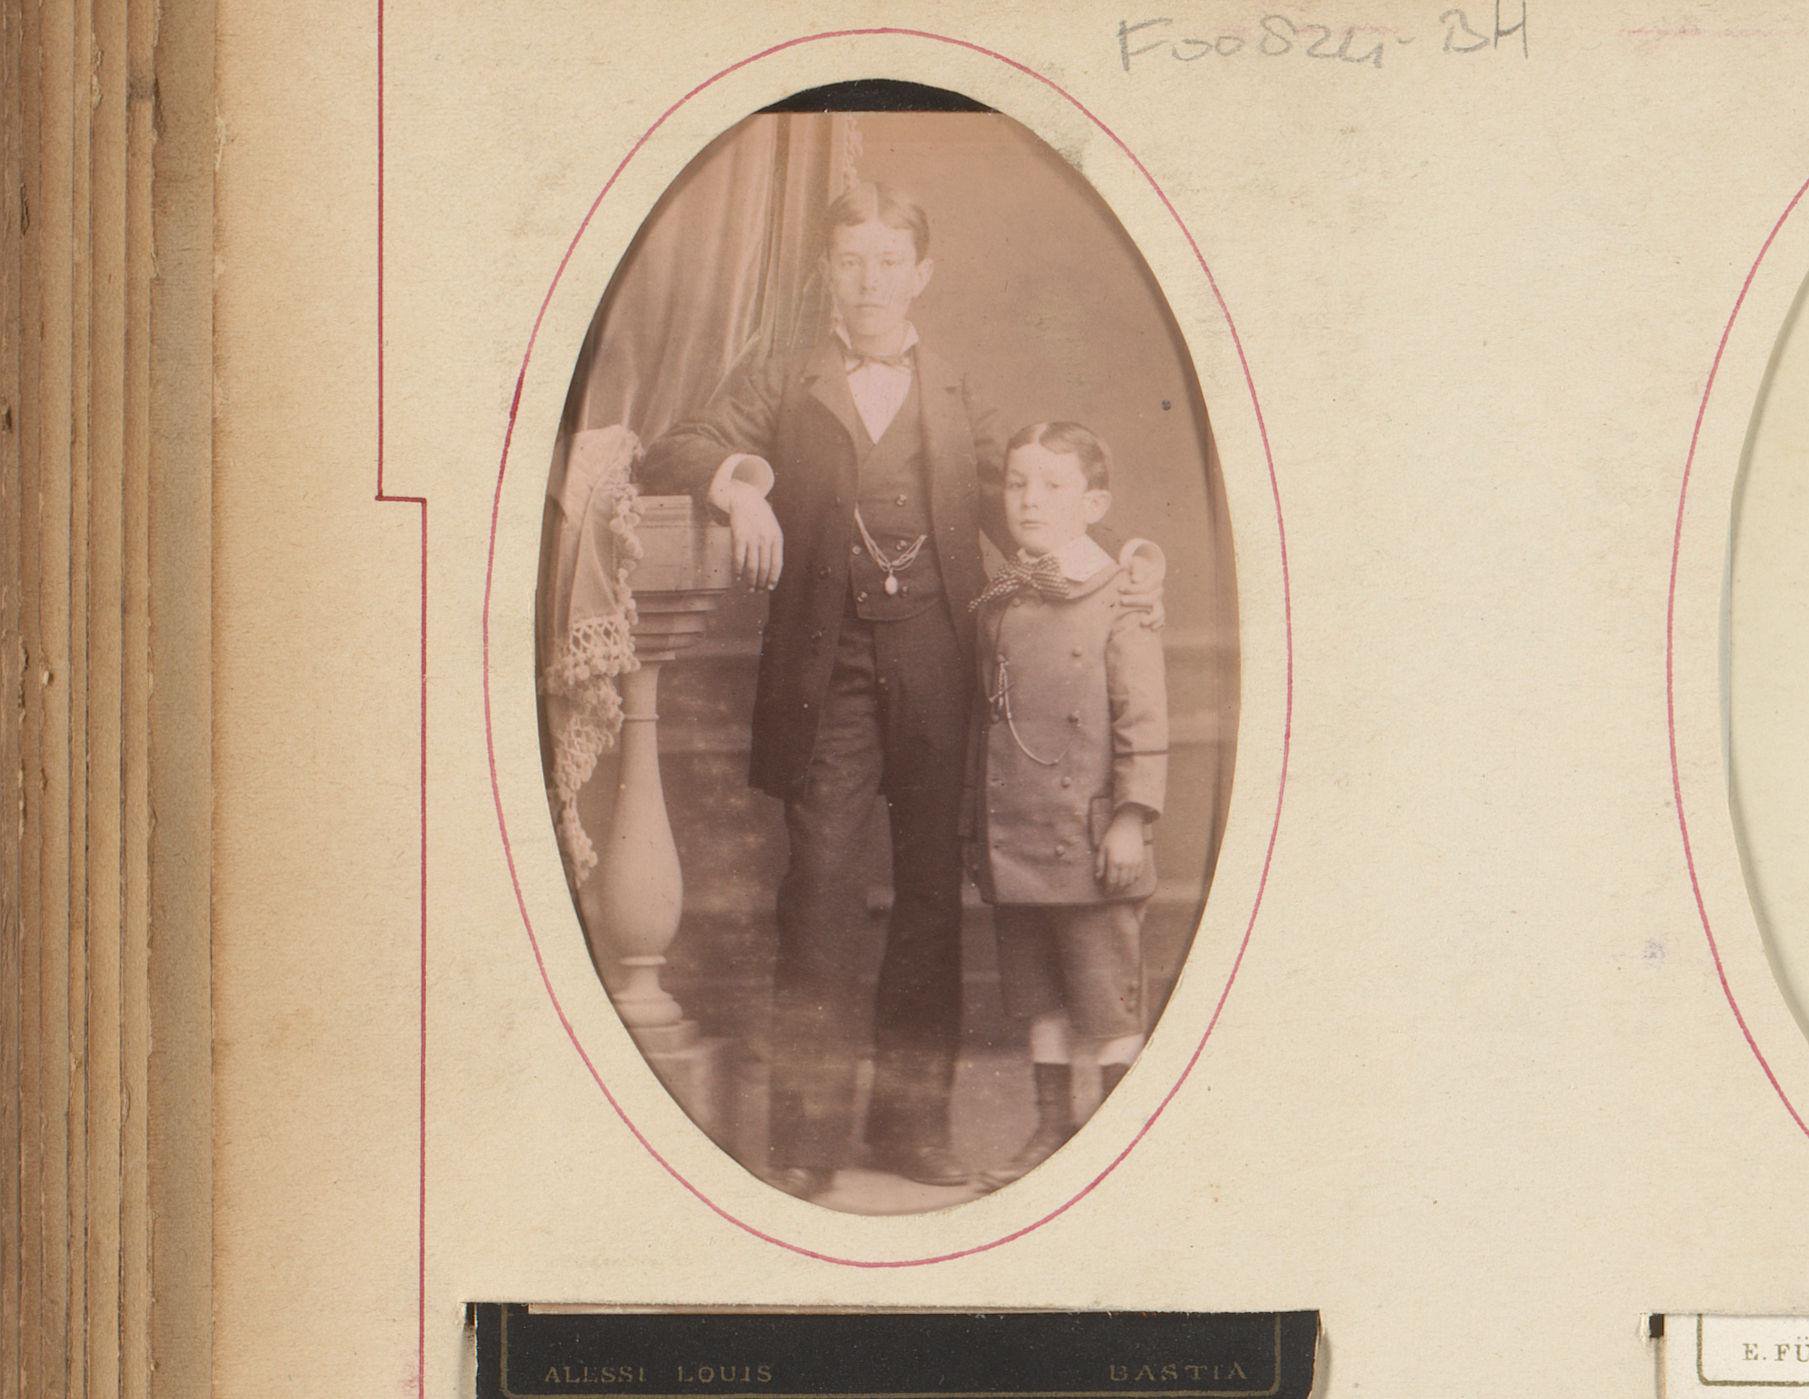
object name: album leaf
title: Dubbelportret van twee kinderen, aangeduid als Fils Pauli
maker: louis alessi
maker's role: fotograaf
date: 1854-1885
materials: cardboard, celluloid, paper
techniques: albumen print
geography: bastia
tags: boy (child between toddler and youth)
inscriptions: inscription: ‘Salon de pose dans le Jardin.’, address: ‘Bastia/ Nouvelle Traverse’